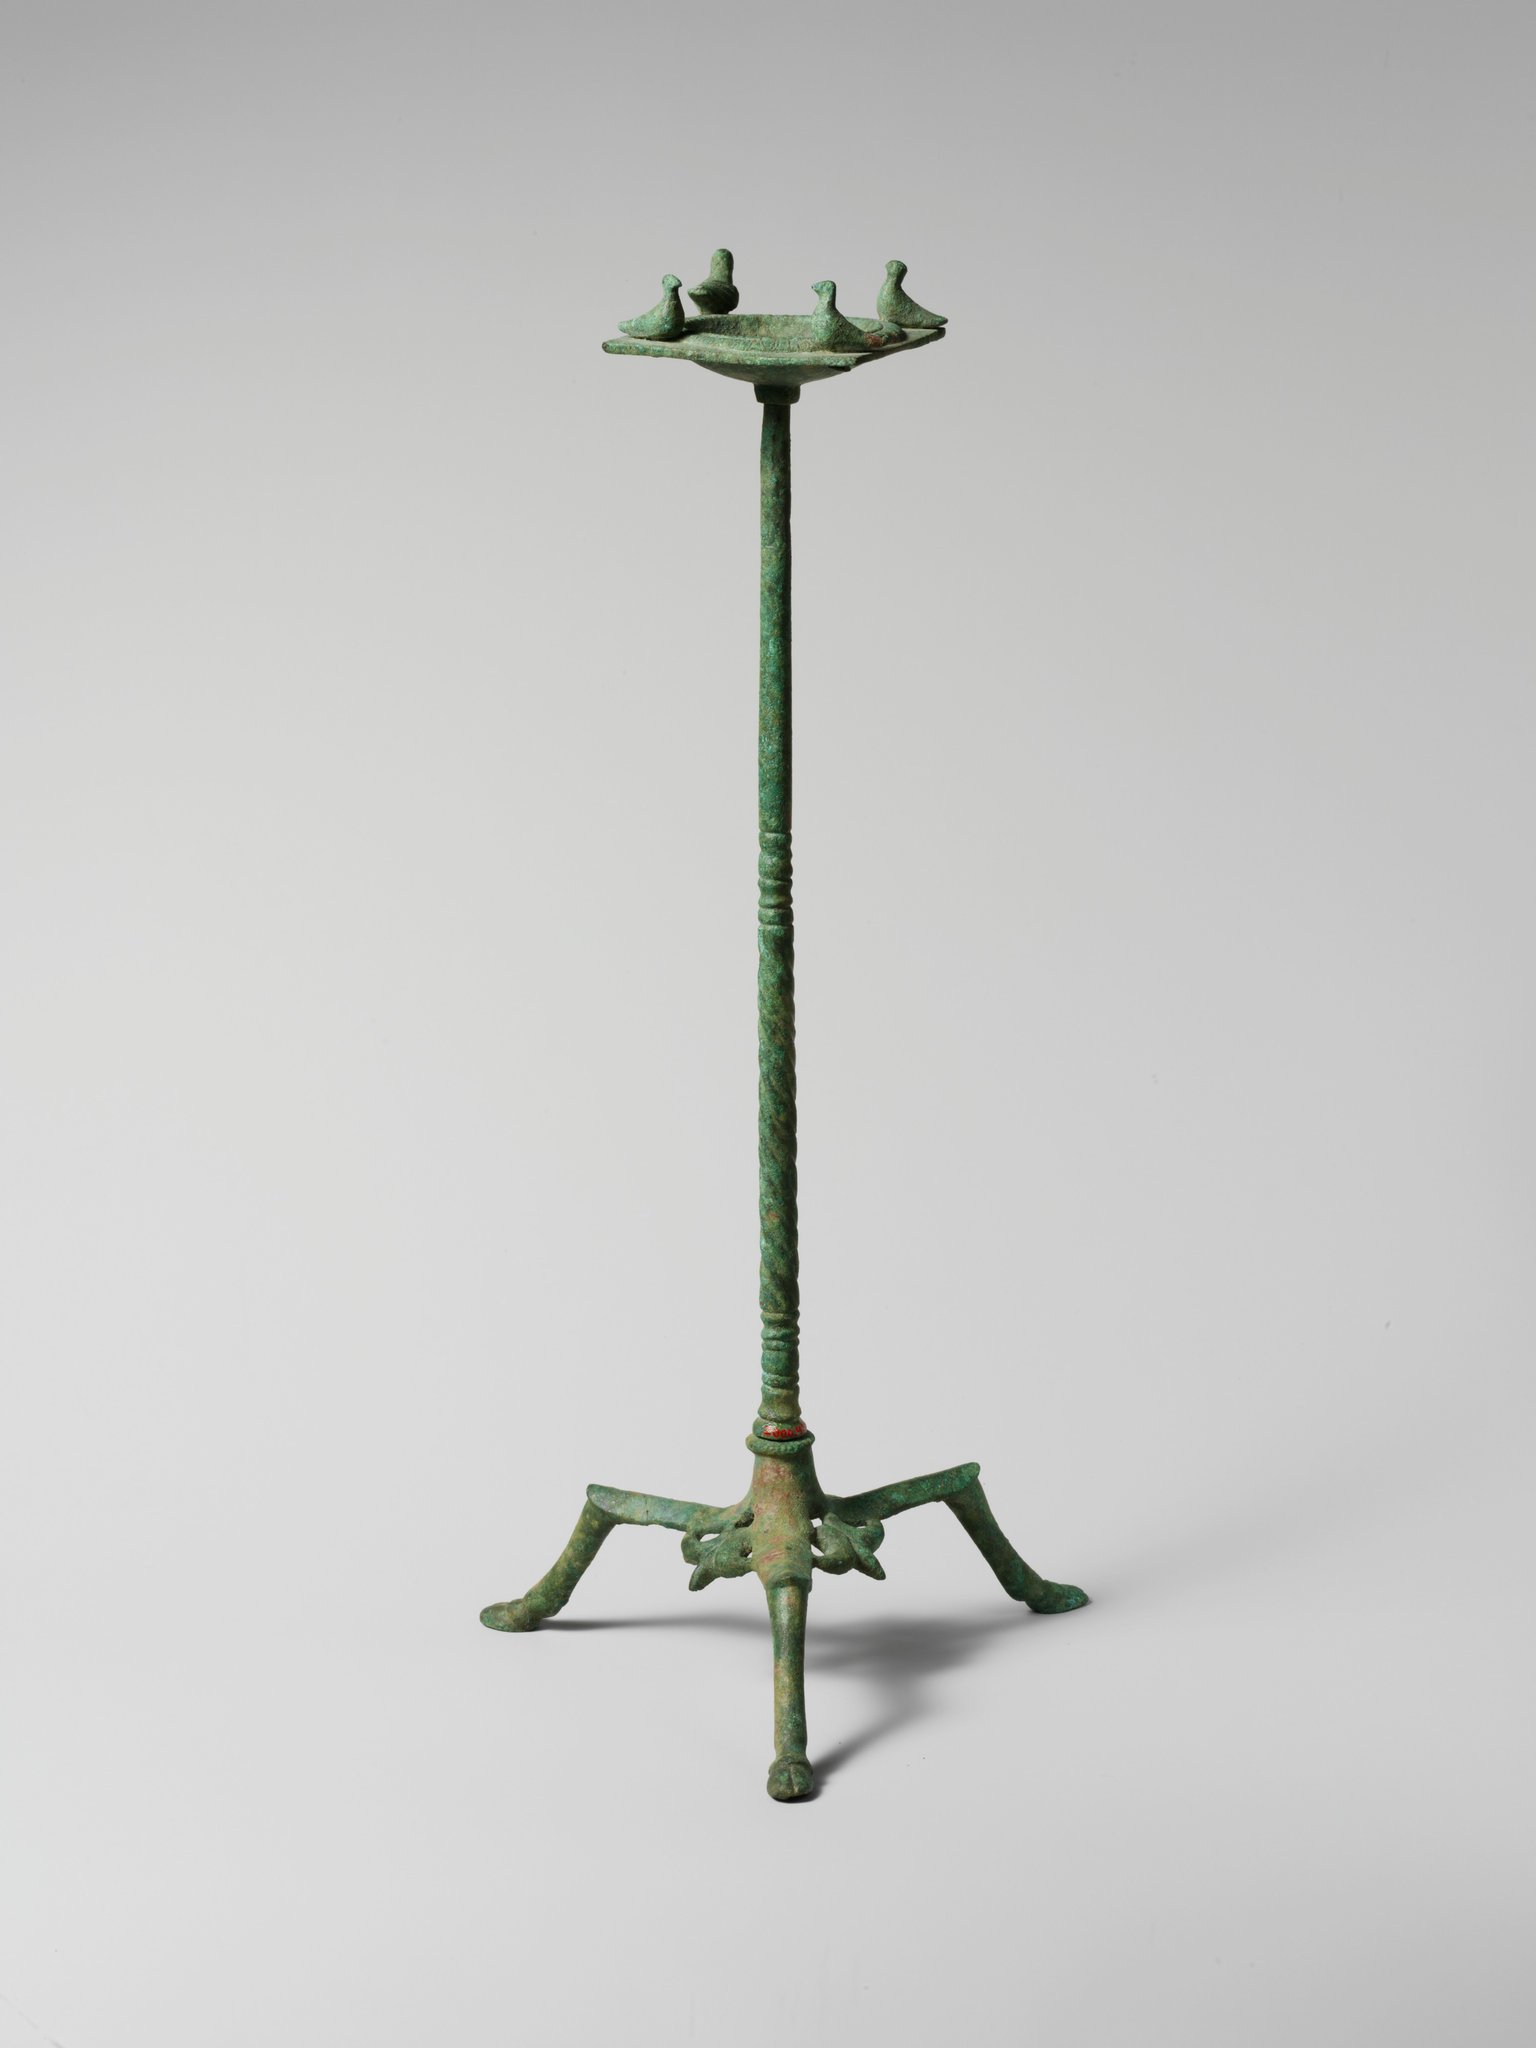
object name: incense burner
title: Bronze incense burner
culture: etruscan or faliscan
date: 300 BCE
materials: bronze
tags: birds